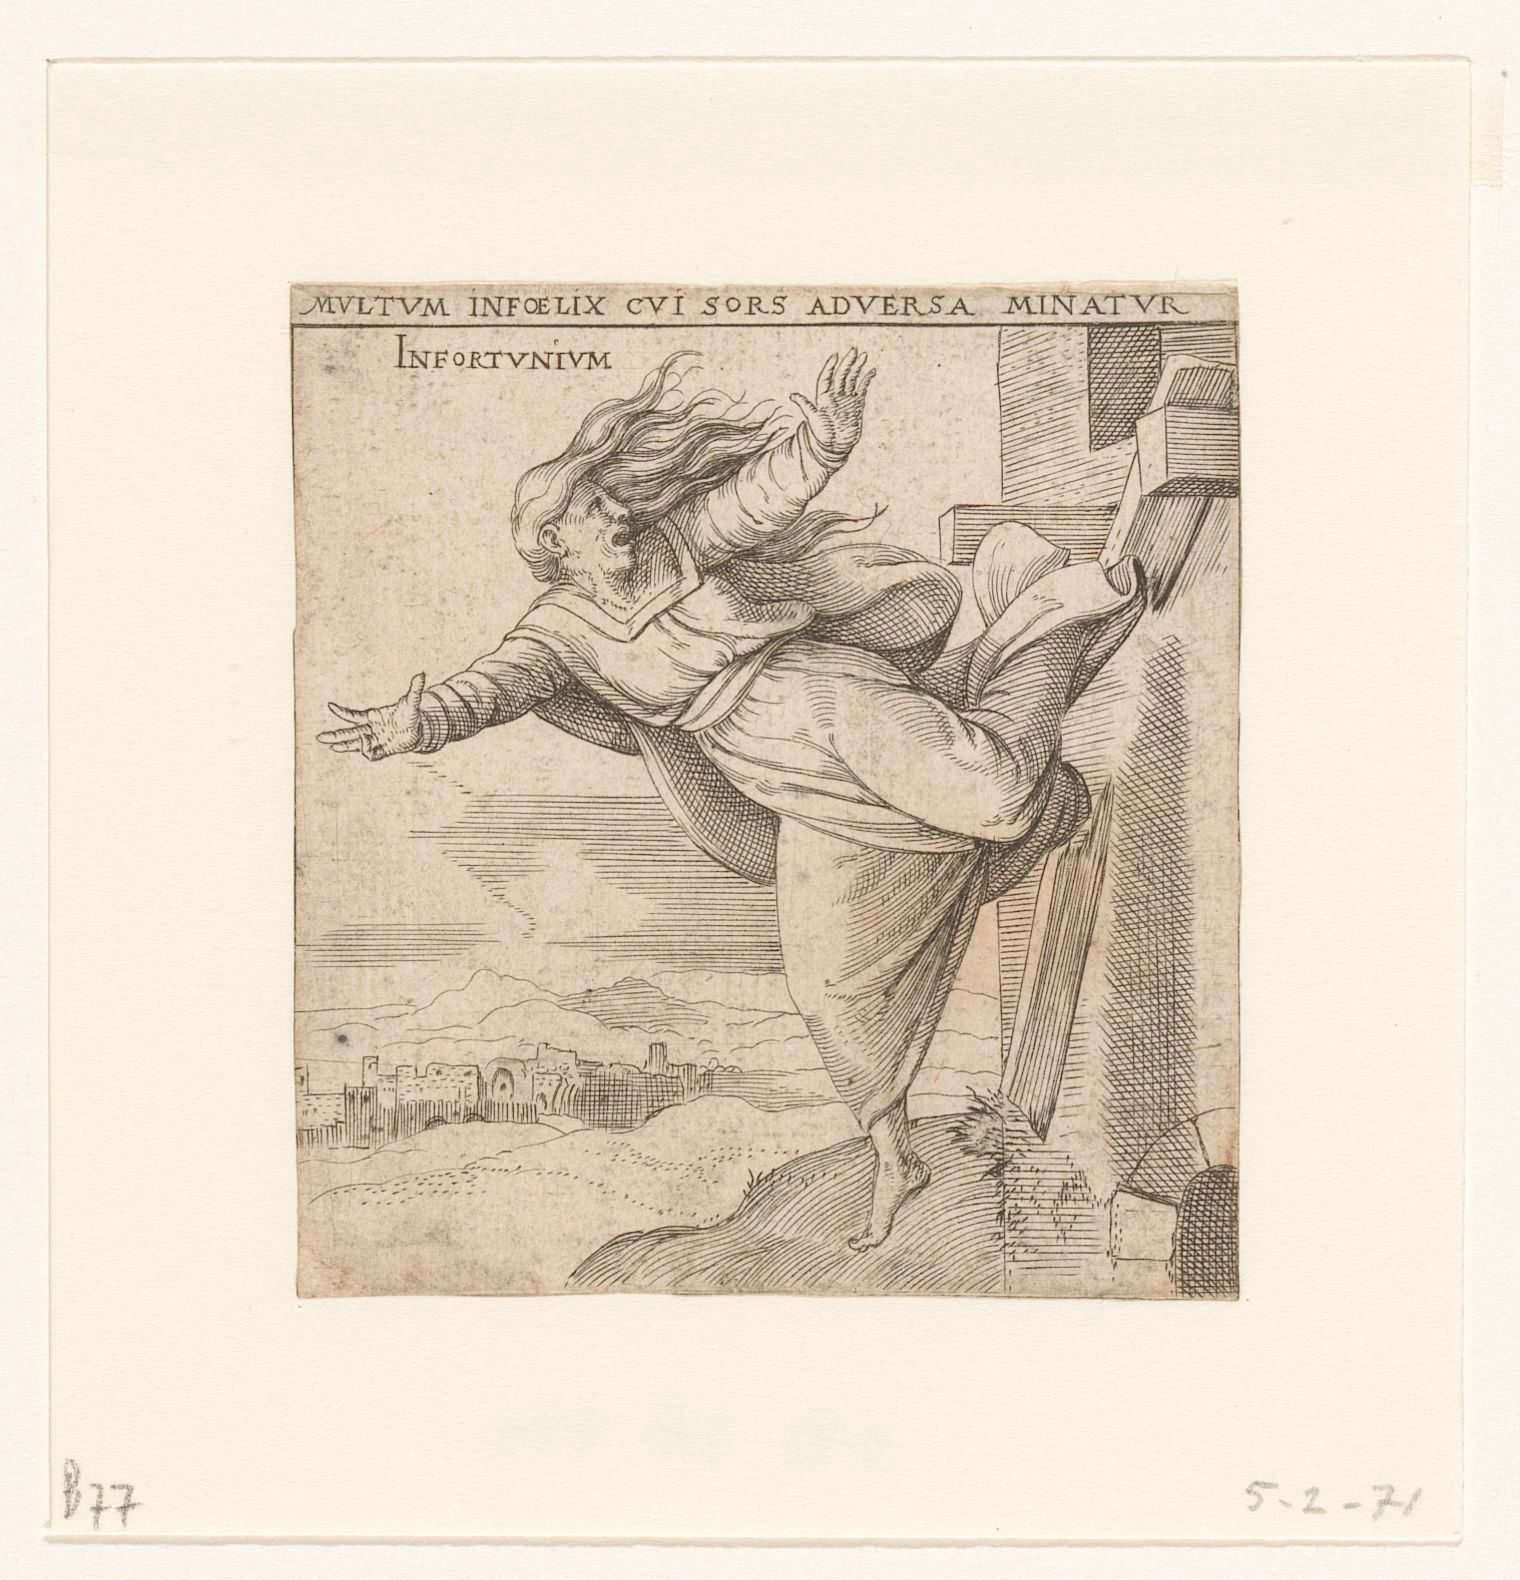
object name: print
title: Infortunium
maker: francesco salviati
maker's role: draughtsman, painter, print maker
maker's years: 1510-1563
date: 1533-1567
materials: paper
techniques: engraving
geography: italy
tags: adversity, misfortune, bad luck; 'fortuna infelice', 'infortunio' (ripa)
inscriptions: collector's mark: Lugt 240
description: Een vrouw vallend uit een toren. Bovenaan een regel Latijnse tekst.